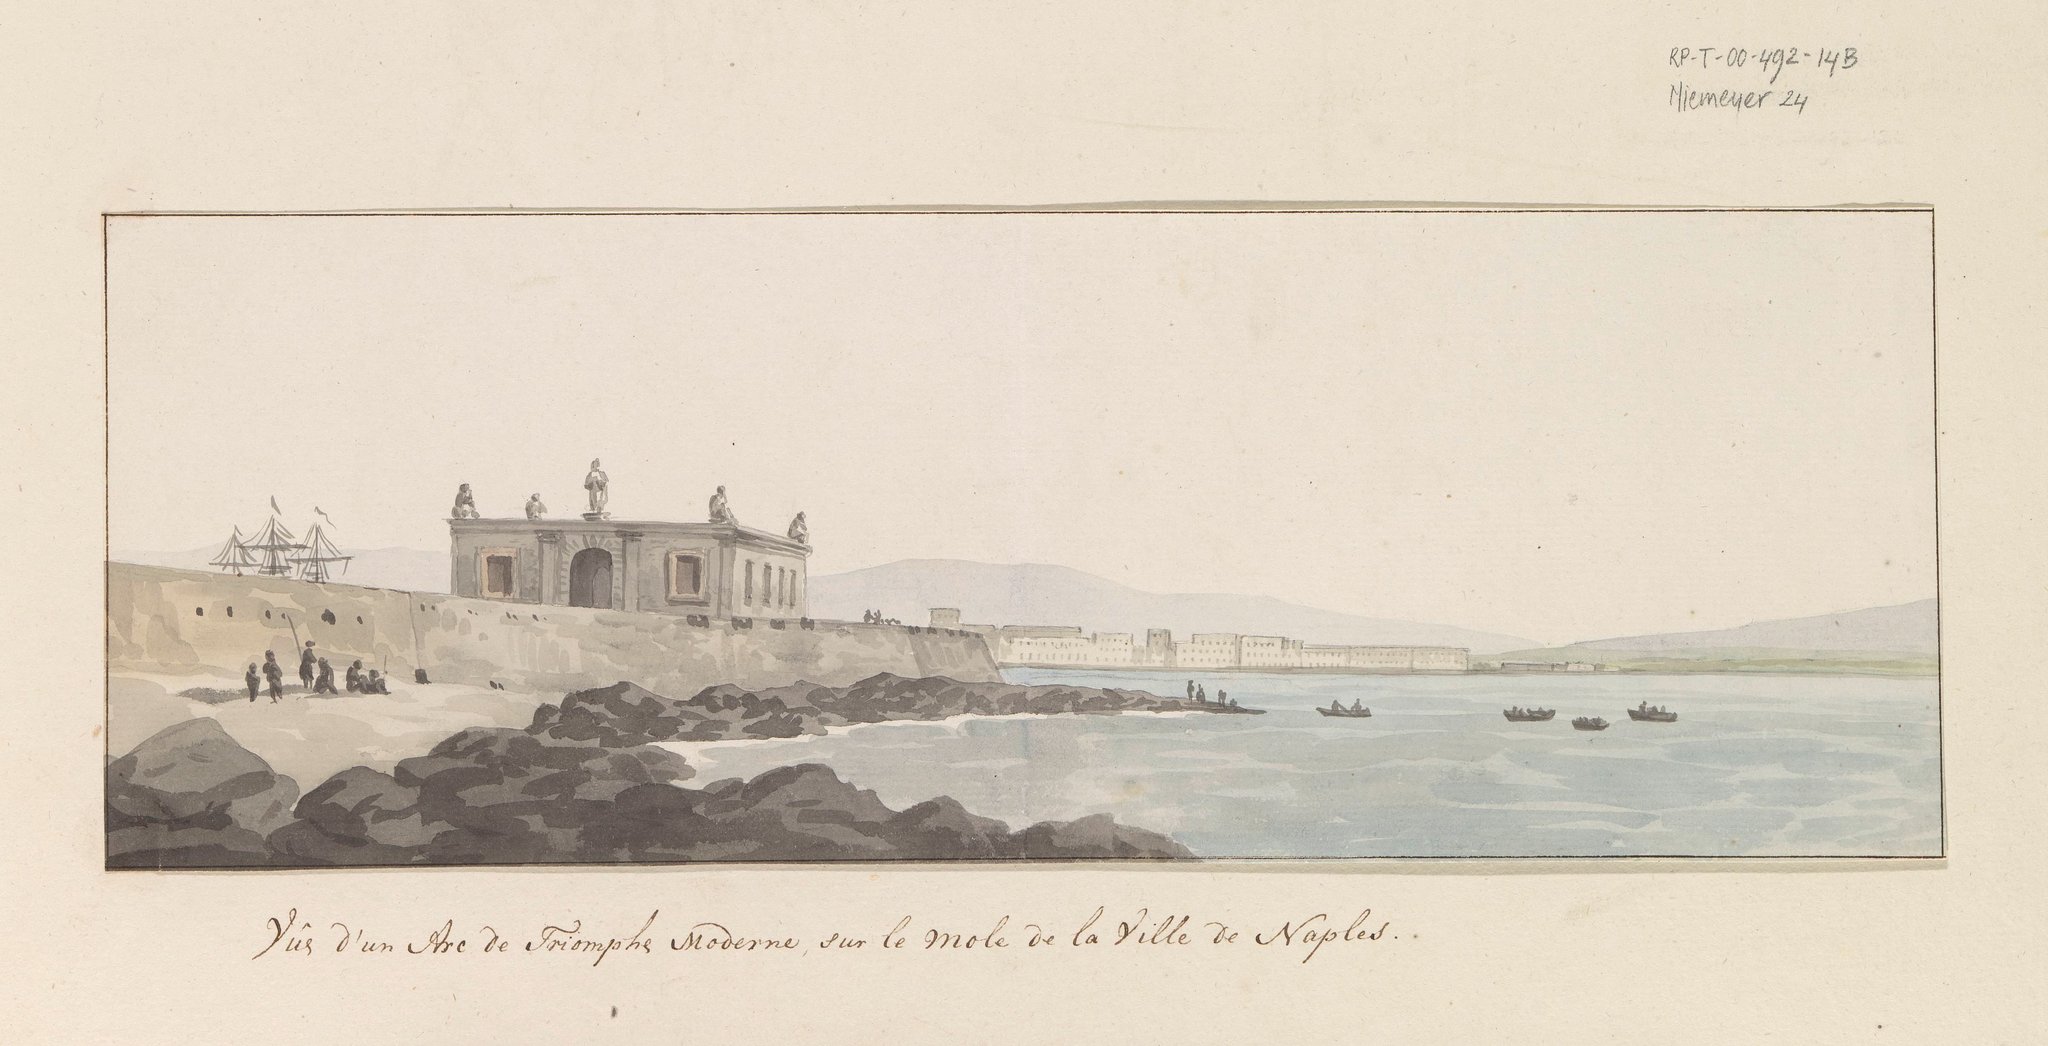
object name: watercolor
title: Voyage en Italie, en Sicile et à Malte - 1778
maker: louis ducros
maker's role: draughtsman, print maker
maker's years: 1748-1810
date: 1778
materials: chalk, paper, watercolor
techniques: brush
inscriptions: number: ‘No 33 Vue d'un Arc de Triomphe moderne, sur le Mole de la Ville de Napels’